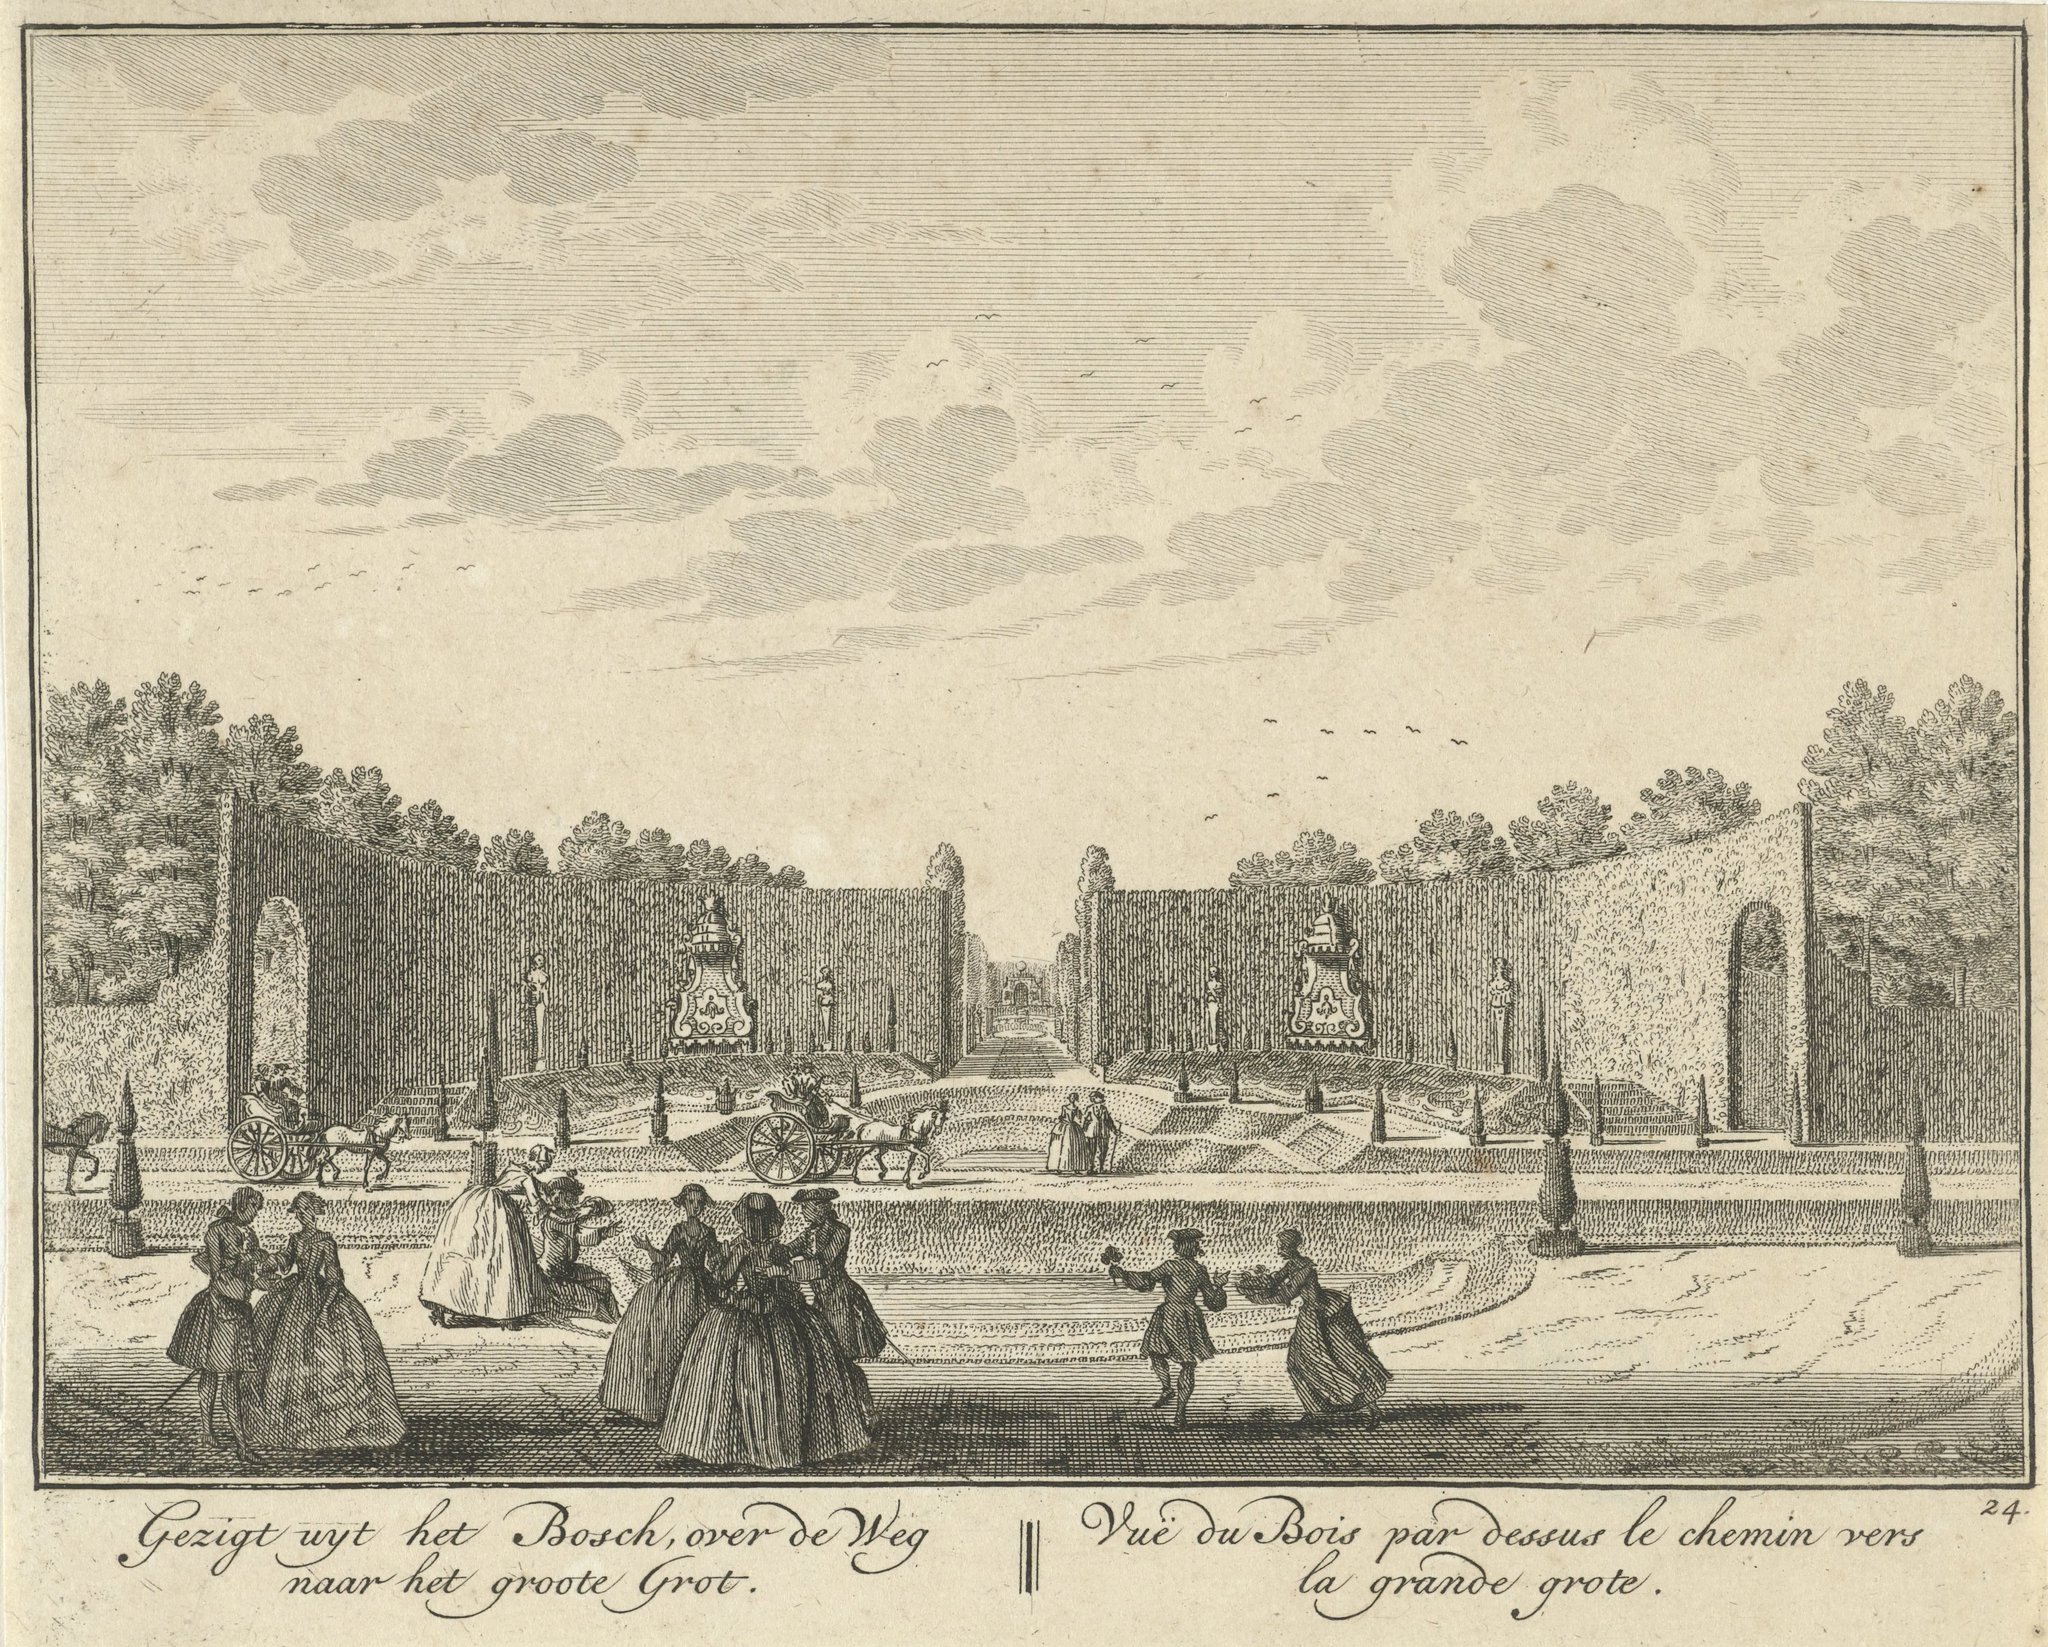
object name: print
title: Het Oud Adelyk huys en Ridderhofstad Ter Meer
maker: hendrik de leth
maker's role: draughtsman, print maker, publisher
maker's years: 1703-1766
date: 1740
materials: paper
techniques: etching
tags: french or architectonic garden; formal garden, country-house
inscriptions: collector's mark: Lugt 2228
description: Gezicht door een haag op de grote grot in de Franse tuin van Huis ter Meer te Maarssen. In de tuin staan converserende groepen figuren, over het tuinpad rijden koetsen. De prent maakt deel uit van een serie met 26 gezichten op Huis ter Meer en het bijbehorende landgoed te Maarssen.